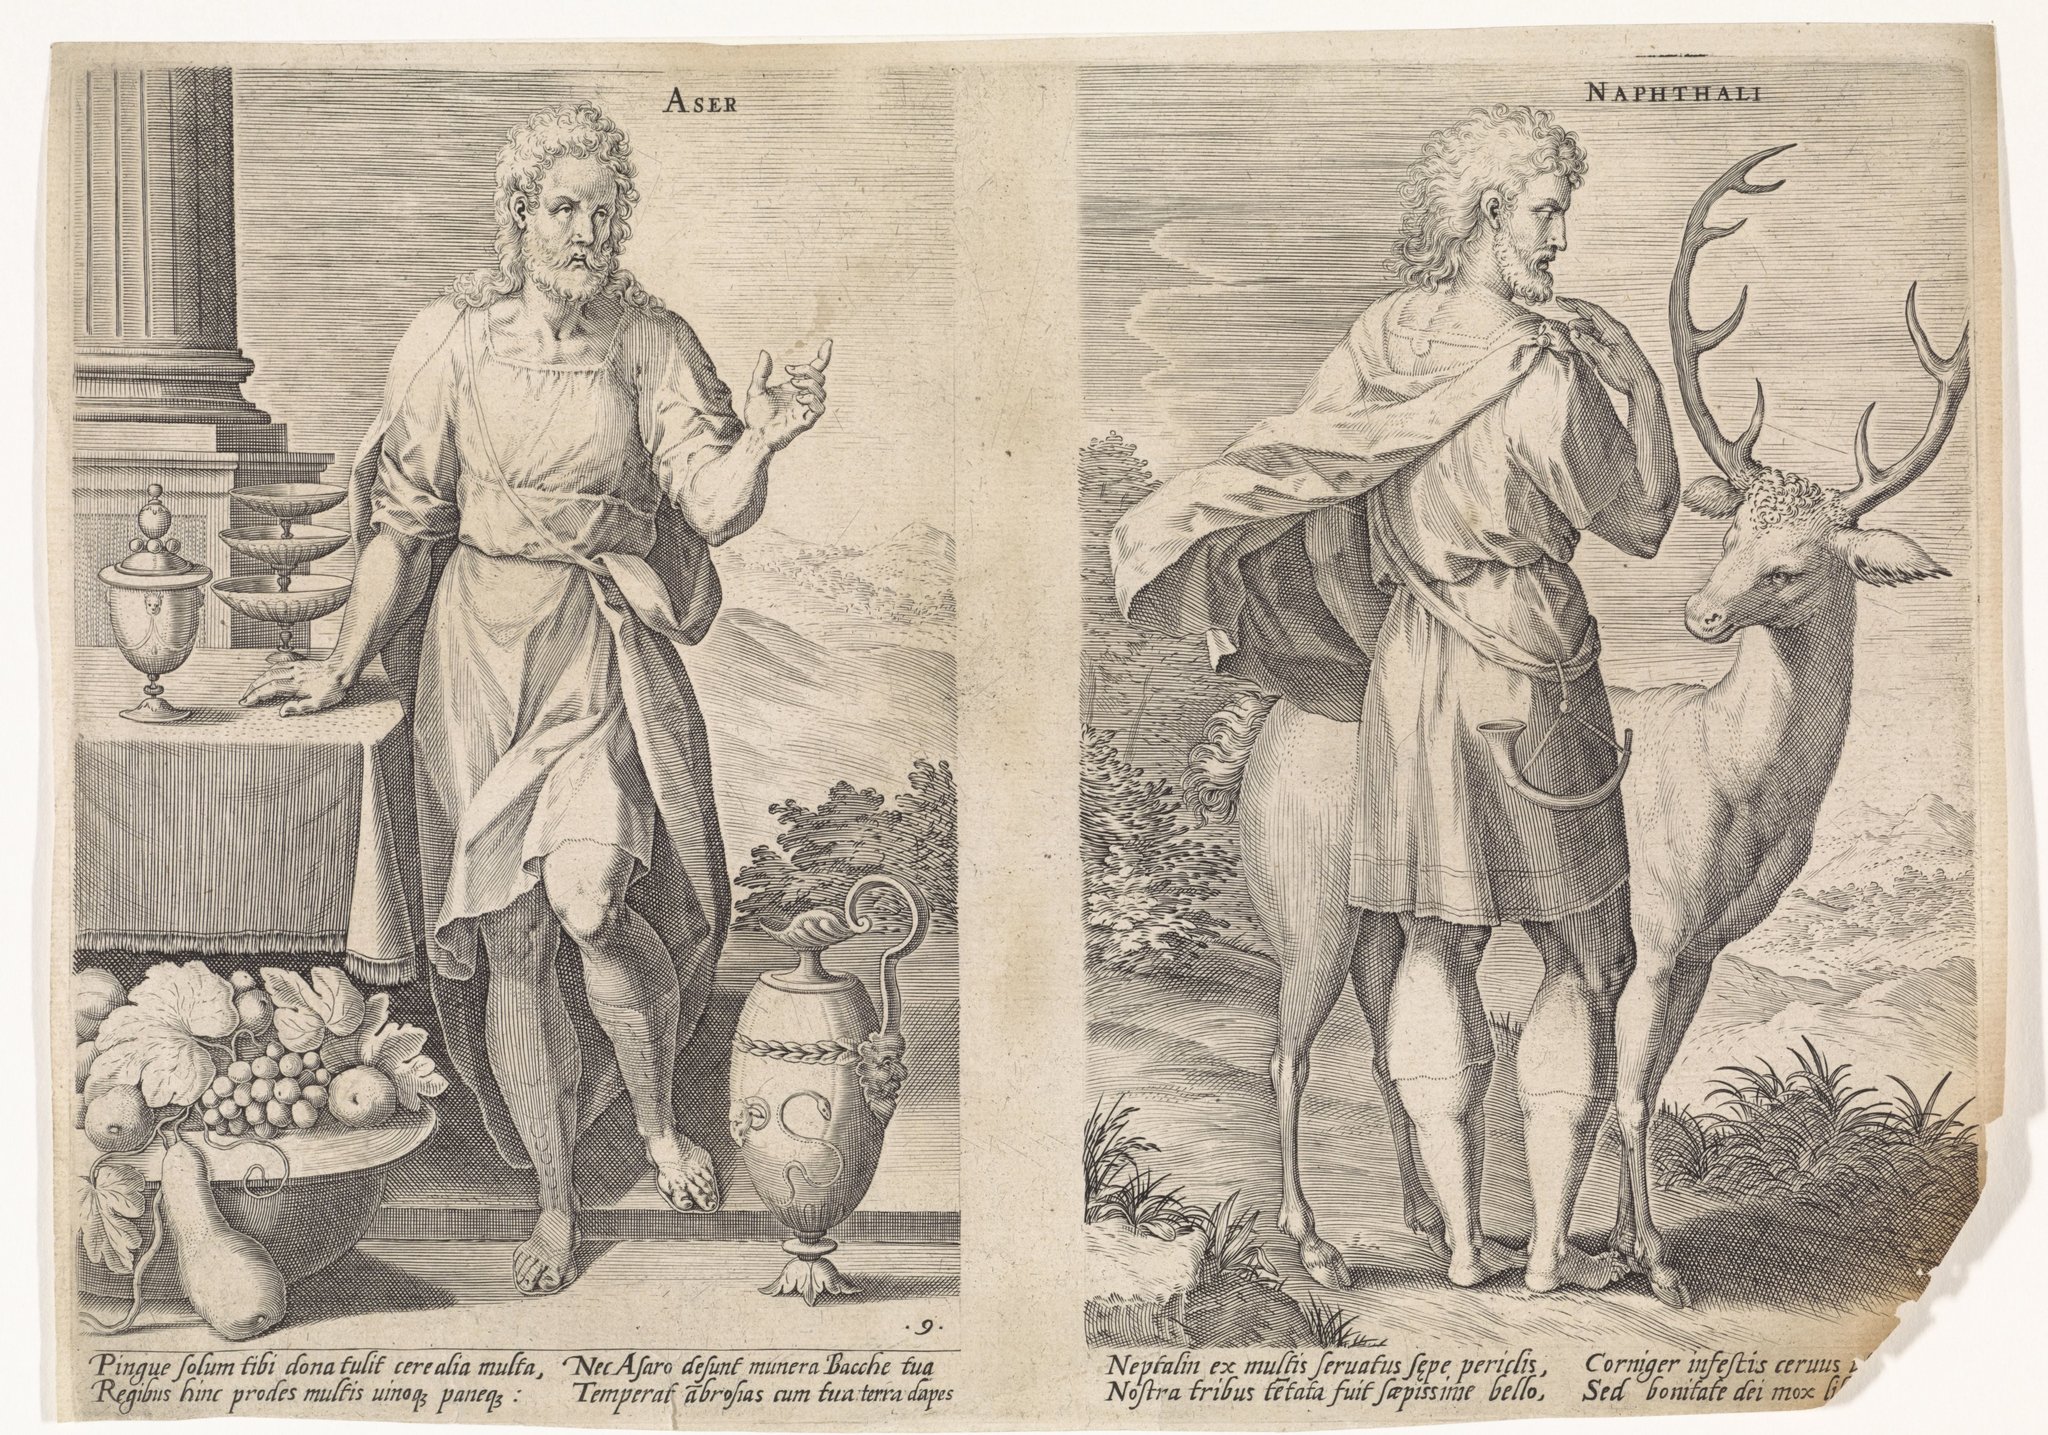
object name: print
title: Stamvaders Aser en Naftali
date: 1585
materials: paper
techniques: engraving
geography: amsterdam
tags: 11i611(naphtali), 11i611(aser)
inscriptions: collector's mark: Lugt 2228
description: Prent gebruikt in: Theatrum biblicum : hoc est historiae sacrae veteris et novi testamenti tabulis aeneis expressae. Opus praesentatissimorum huius ac superioris seculi pictorum atque sculptorum, summo studio conquisitum et in lucem editum. Amsterdam: Claes Jansz. Visscher, 1643.